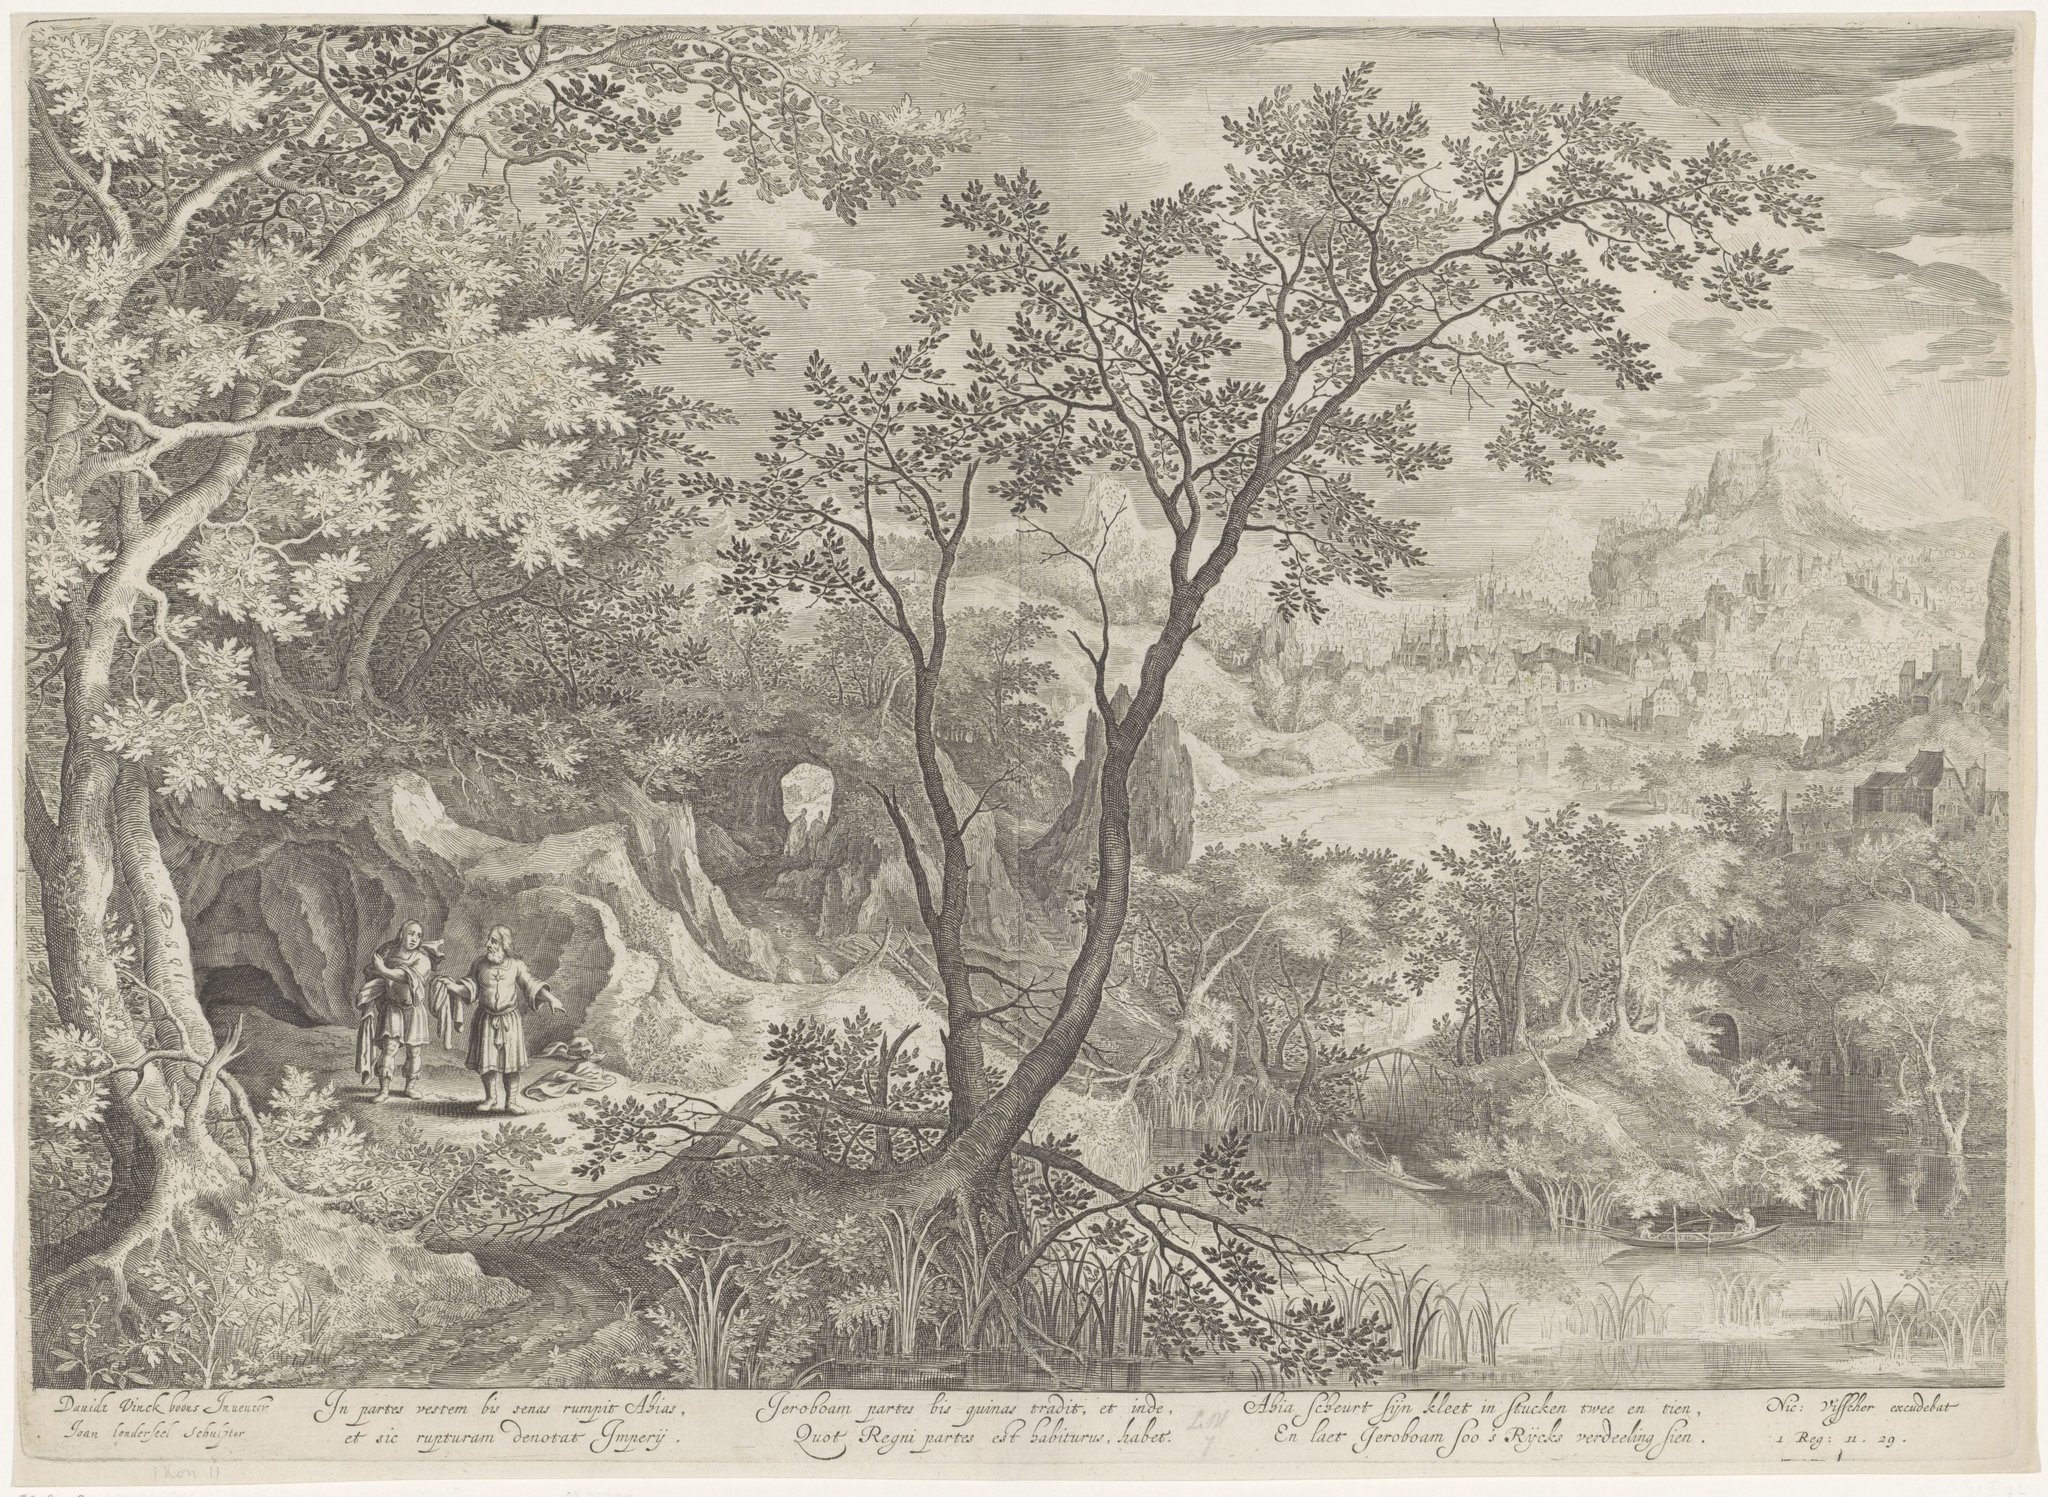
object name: print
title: Jerobeam en de profeet Achia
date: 1585-1625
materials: paper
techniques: engraving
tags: meeting of jeroboam and the prophet ahijah; ahijah rends his garment in twelve pieces, ten of which he gives to jeroboam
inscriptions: collector's mark: Lugt 2228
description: De Amsterdamse uitgever Claes Jansz. Visscher (II) produceerde vanaf de jaren ’30 van de zeventiende eeuw grote Bijbelse prenten op zogenaamd royaal-formaat papier (ca. 480 x 580 mm). Na zijn dood in 1652 zette zijn zoon Nicolaes Visscher (I) het bedrijf voort en zo ook de uitgave van Royaalbijbelprenten. Toen Nicolaes in 1679 overleed nam zijn zoon Nicolaes Visscher (II) het bedrijf over en gaf kort hierna, omstreeks 1680, een fondslijst uit. Hierin worden 130 prenten met Bijbelse voorstellingen op royaalpapier beschreven (zie documentatie J. van der Waals). Complete prentbijbels op royaal-formaat werden door vader en zoon Nicolaes Visscher uitgegeven onder de titel Historiae Sacrae Veteris et Novi Testamenti. De bladen werden echter ook los verkocht en konden worden gecombineerd met Royaalbijbel-prenten van andere uitgevers. Verschillende Amsterdamse uitgevers brachten namelijk ook bijbelprenten op royaal-formaat uit, onder wie Clement de Jonghe en Cornelis Danckerts. De door de firma Visscher uitgegeven prenten zijn veelal vervaardigd door anonieme prentmakers naar voorbeeld van verschillende zestiende- en zeventiende-eeuwse Bijbelse prenten en prentreeksen. Veelal moesten de composities worden aangepast aan het grotere en langgerekte royaal-formaat. Daarnaast zijn er ook grote bladen van bekende prentmakers zoals Jan van Londerseel, Pieter Nolpe, Jacques de Gheyn (II) en Jan Harmensz. Muller opgenomen in de categorie ‘Bybelsche Figuren, op Royaal-bladen’ in de fondslijst van Visscher. Prent mogelijk gebruikt in: Historiae Sacrae Veteris et Novi Testamenti (Royaalbijbel). Amsterdam: Nicolaes Visscher (I) en (II), [1652-1702]. In de fondslijst van Nicolaes Visscher II (ca. 1680) is het onderwerp van deze prent onder de titel 'Bybelsche Figuren, op Royaal-bladen. bestaande uyt de volgende historien.' als volgt genummerd: 45.